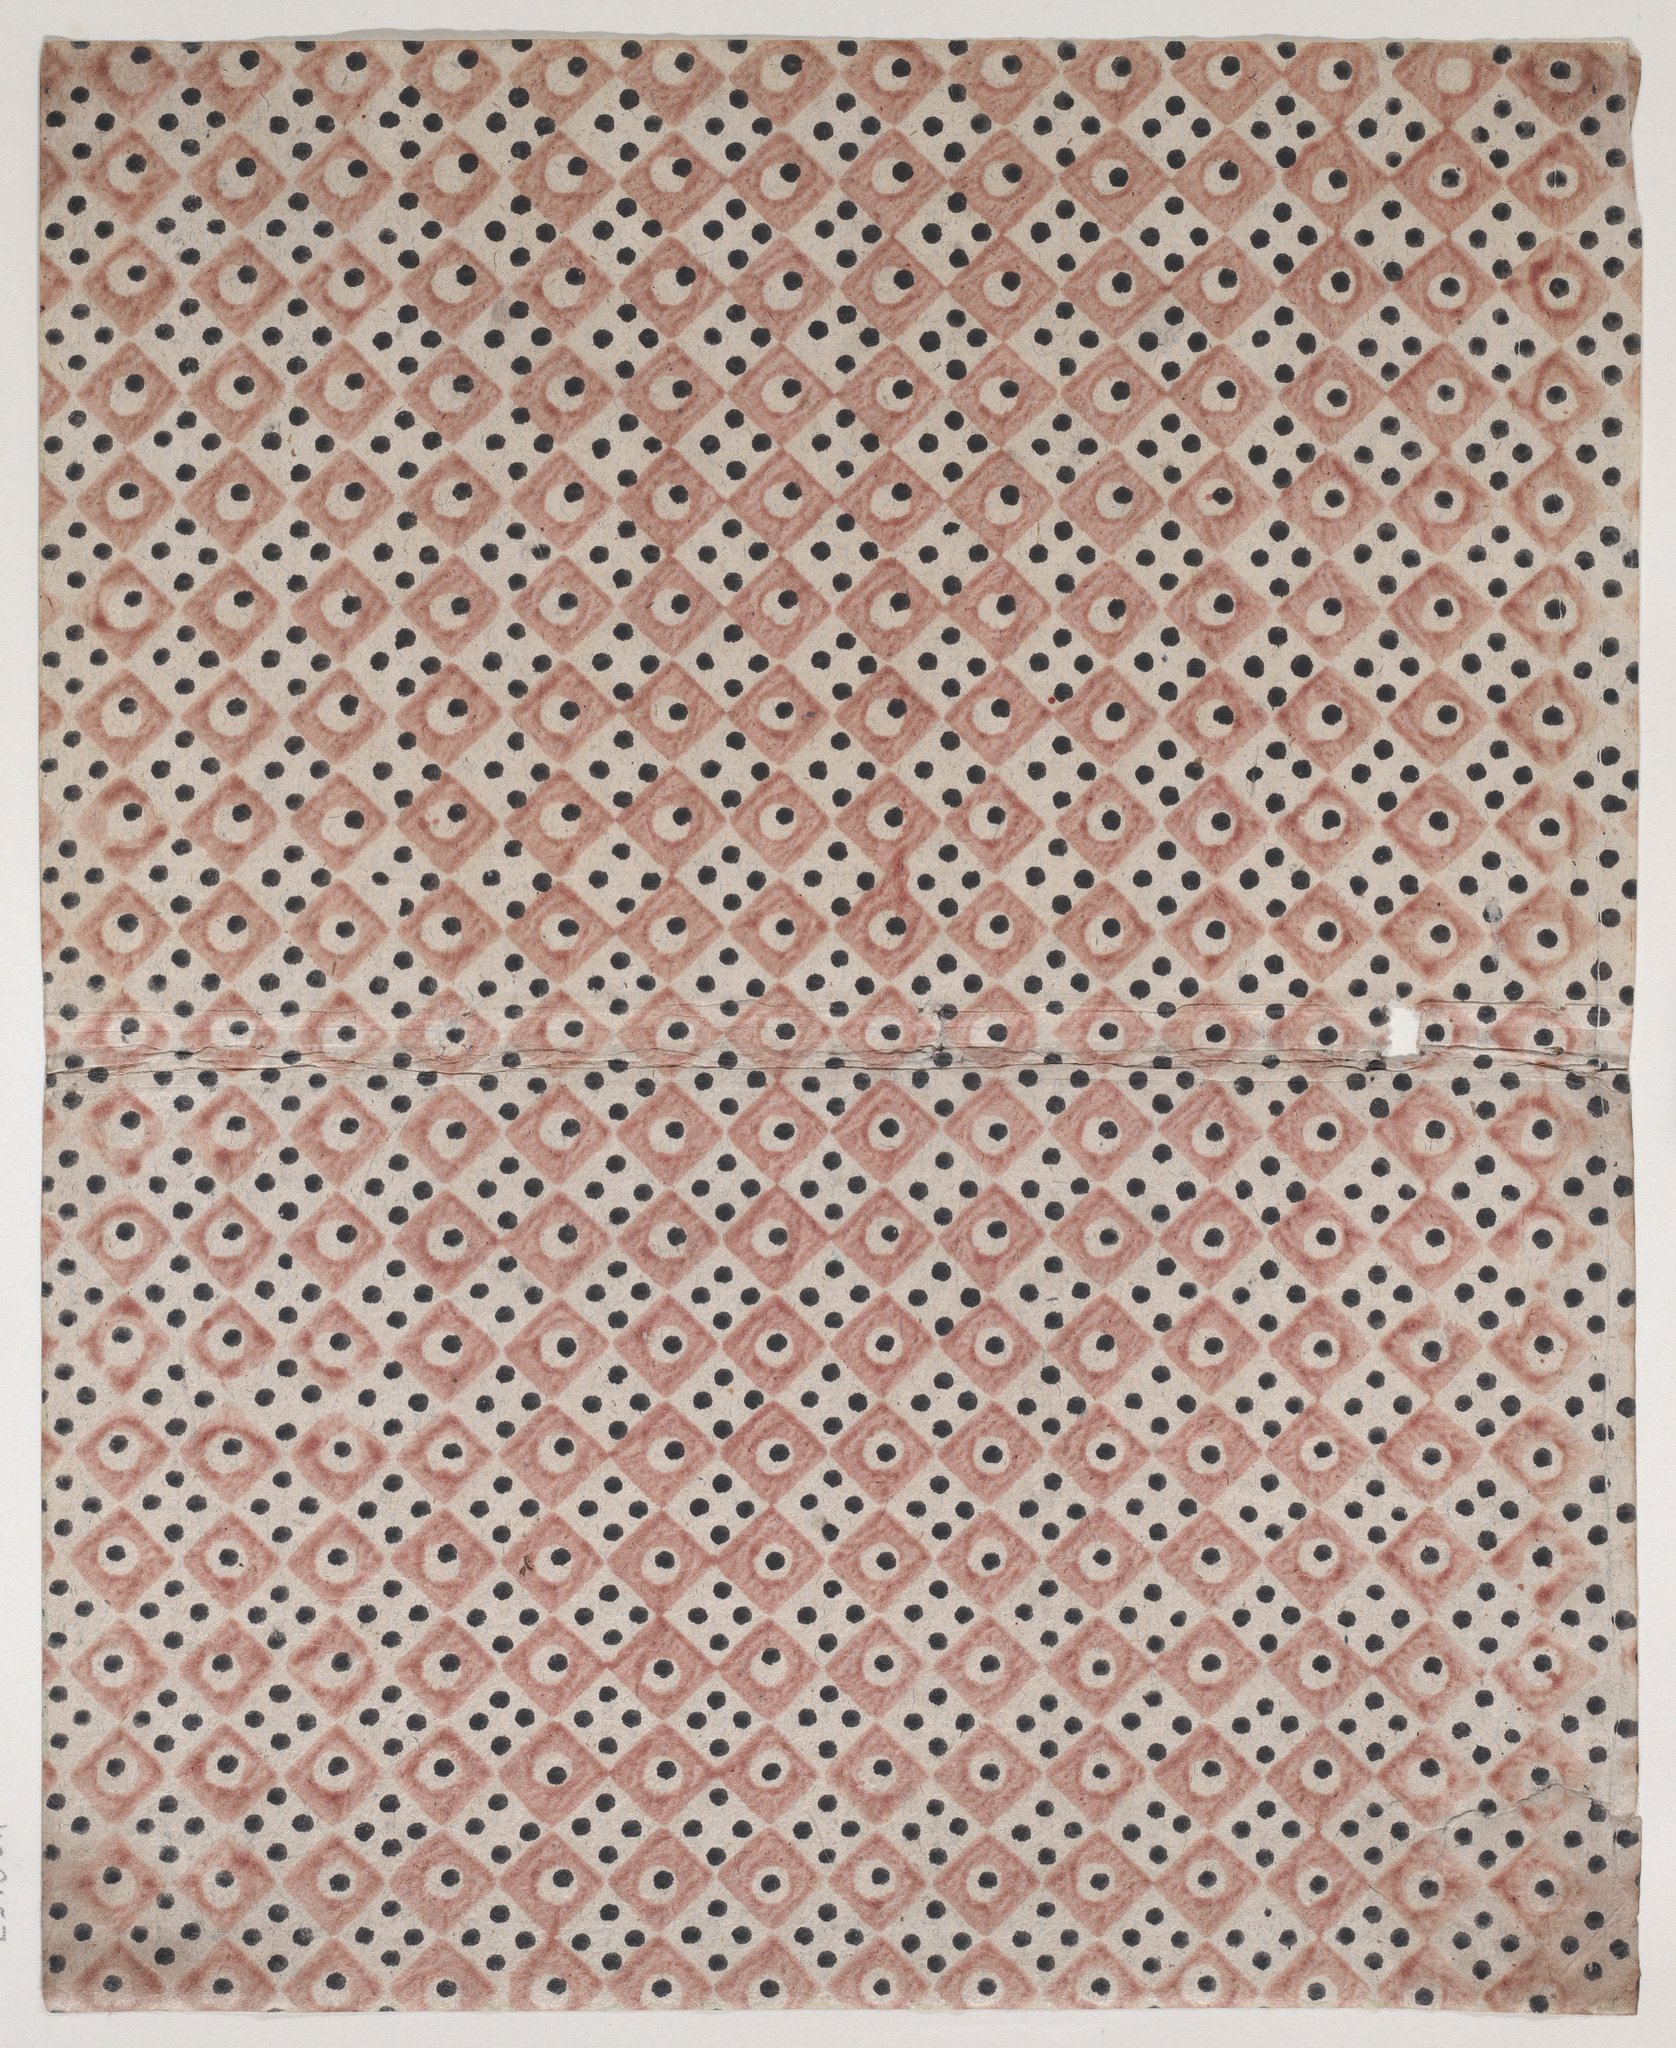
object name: print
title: Book cover with overall pattern of red and black squares and dots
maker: Anonymous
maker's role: artist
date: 1801-1900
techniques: relief print